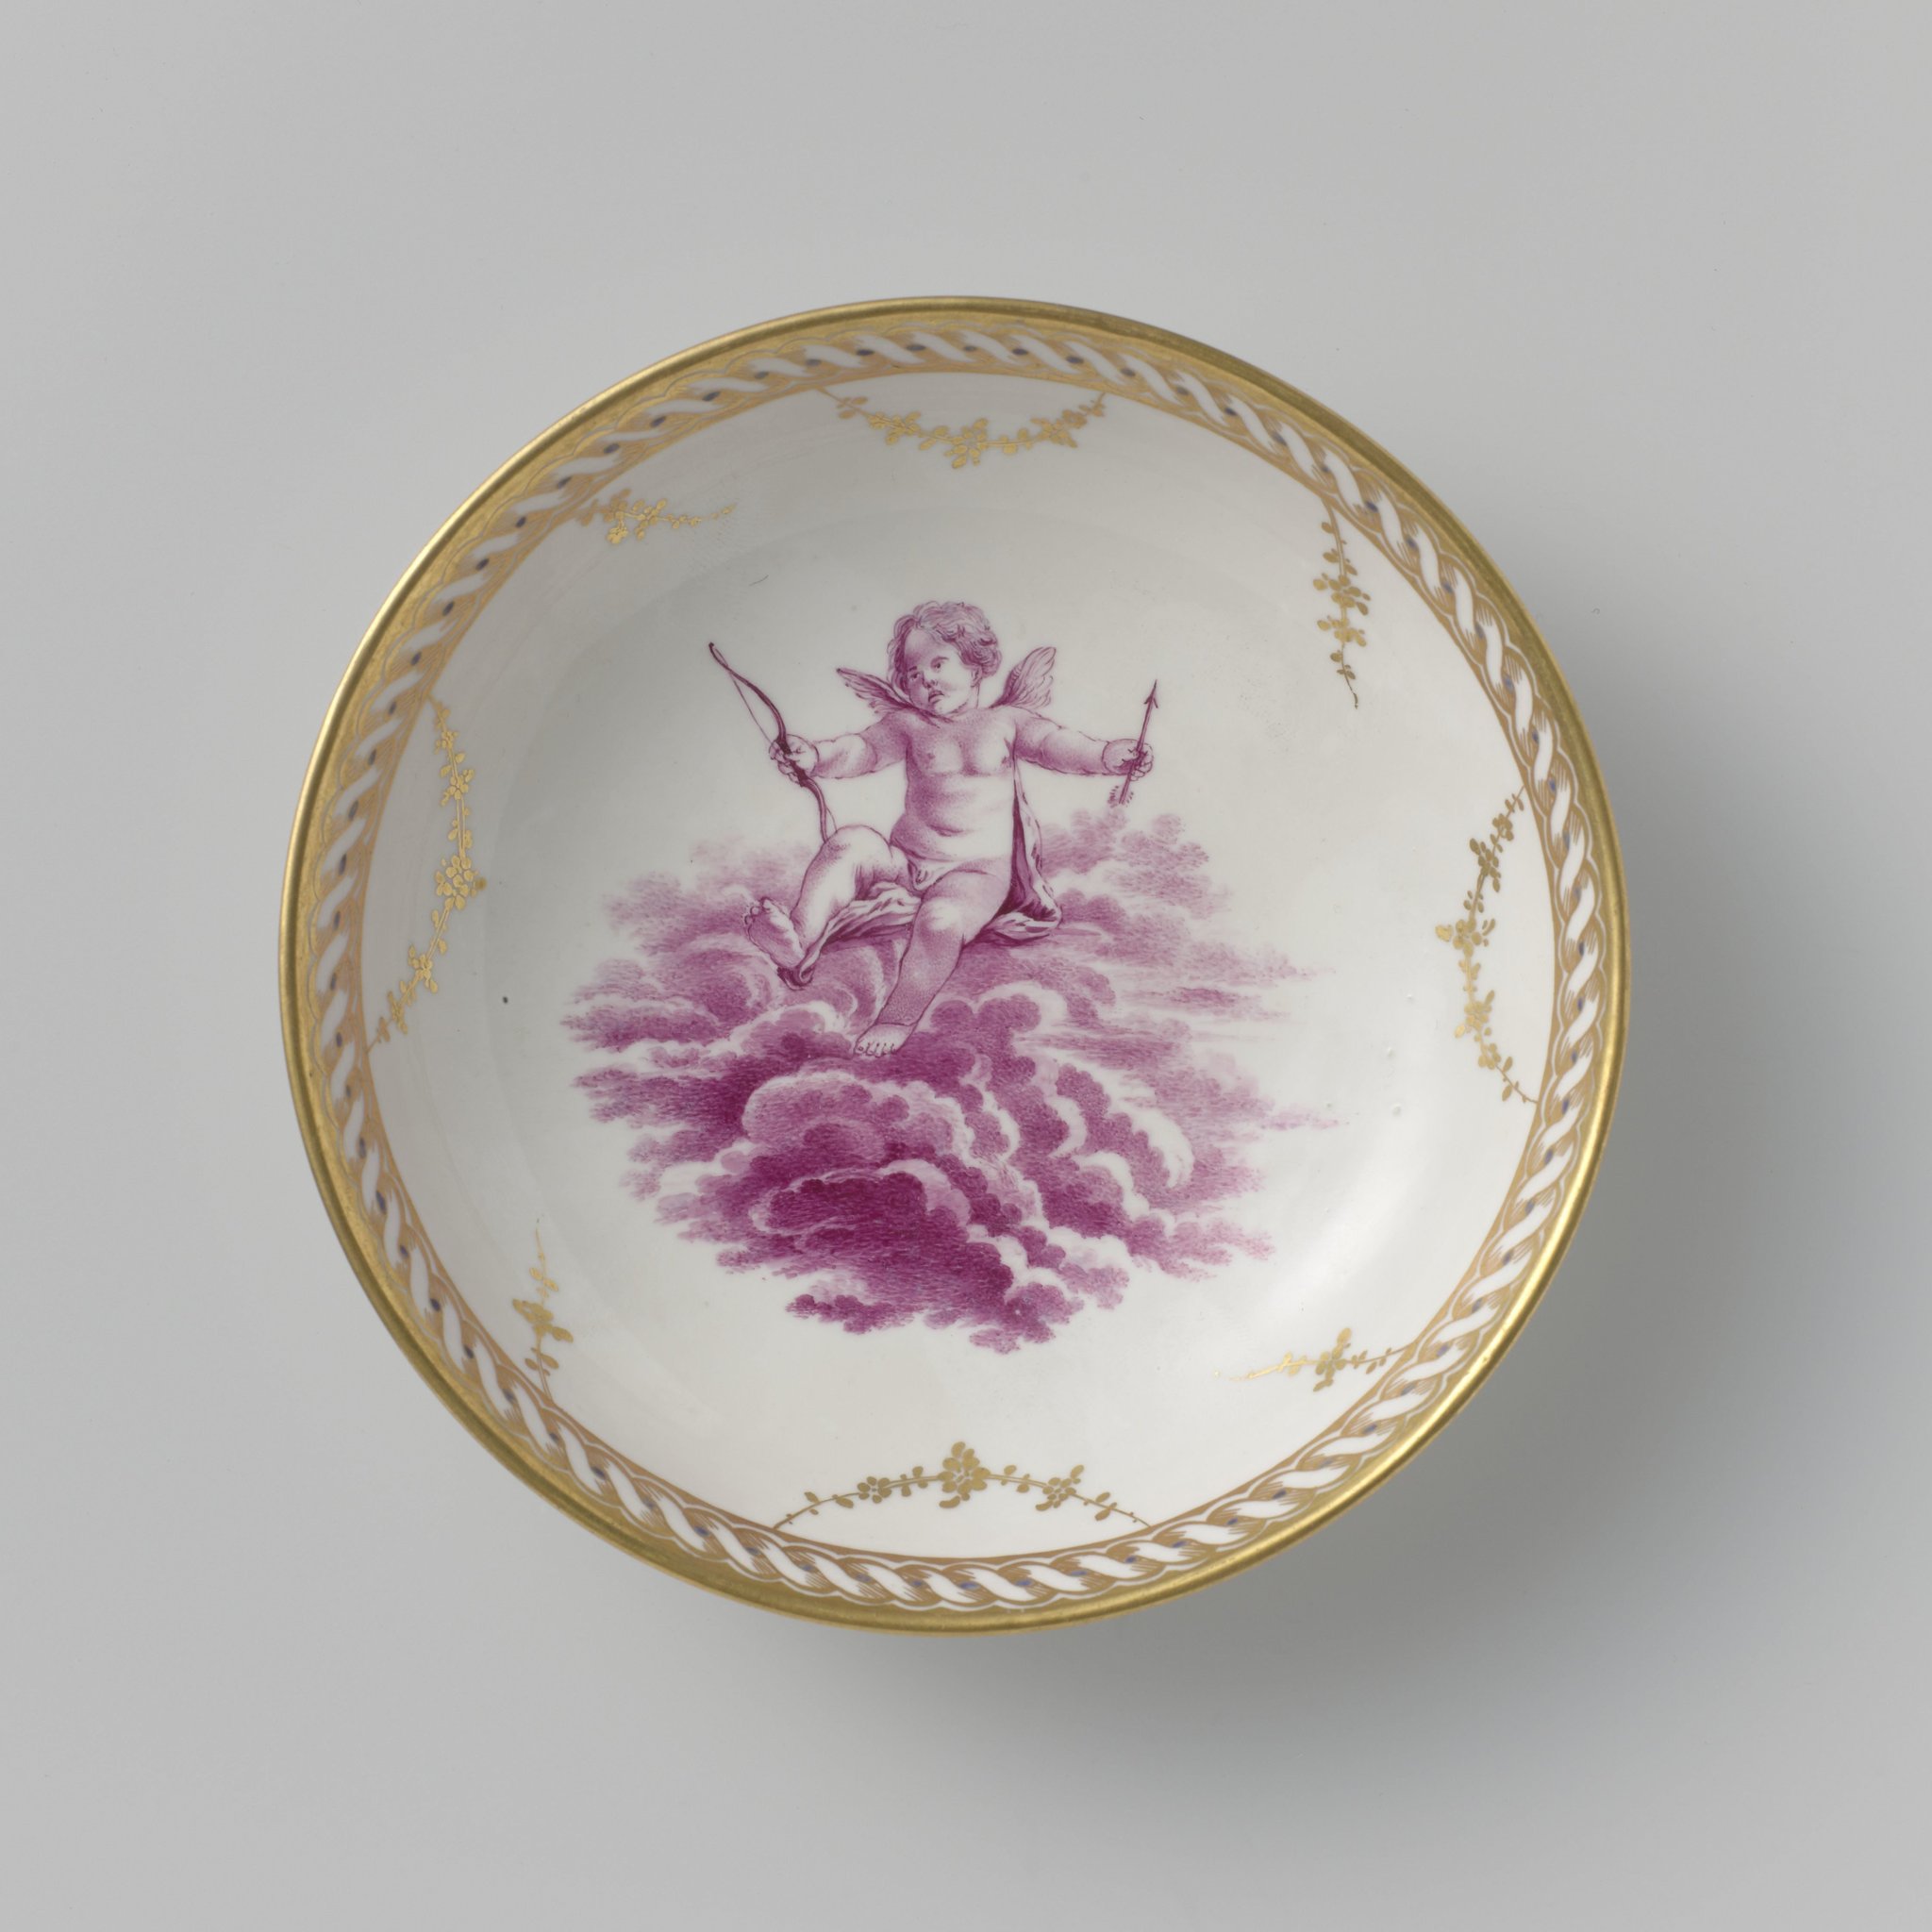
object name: platter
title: Saucer with a putto on clouds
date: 1785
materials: glaze, gold, paint, porcelain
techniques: firing, forming, gilding, turning, vitrification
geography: the hague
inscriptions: mark: ‘ooievaar’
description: Schotel van porselein, beschilderd op het glazuur in roze (camaïeu) en goud. Op het plat een putto met een pijl en boog op een wolk. De binnenrand met een gedraaide band, waaraan guirlandes en bloemtakken hangen. Gouden rand. Gemerkt op de onderzijde met de ooievaar.